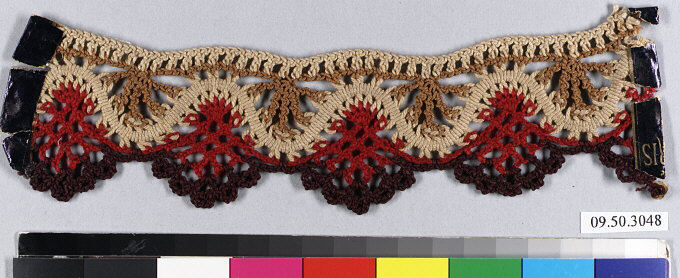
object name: sample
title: Crochet Work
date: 1801-1900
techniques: crochet